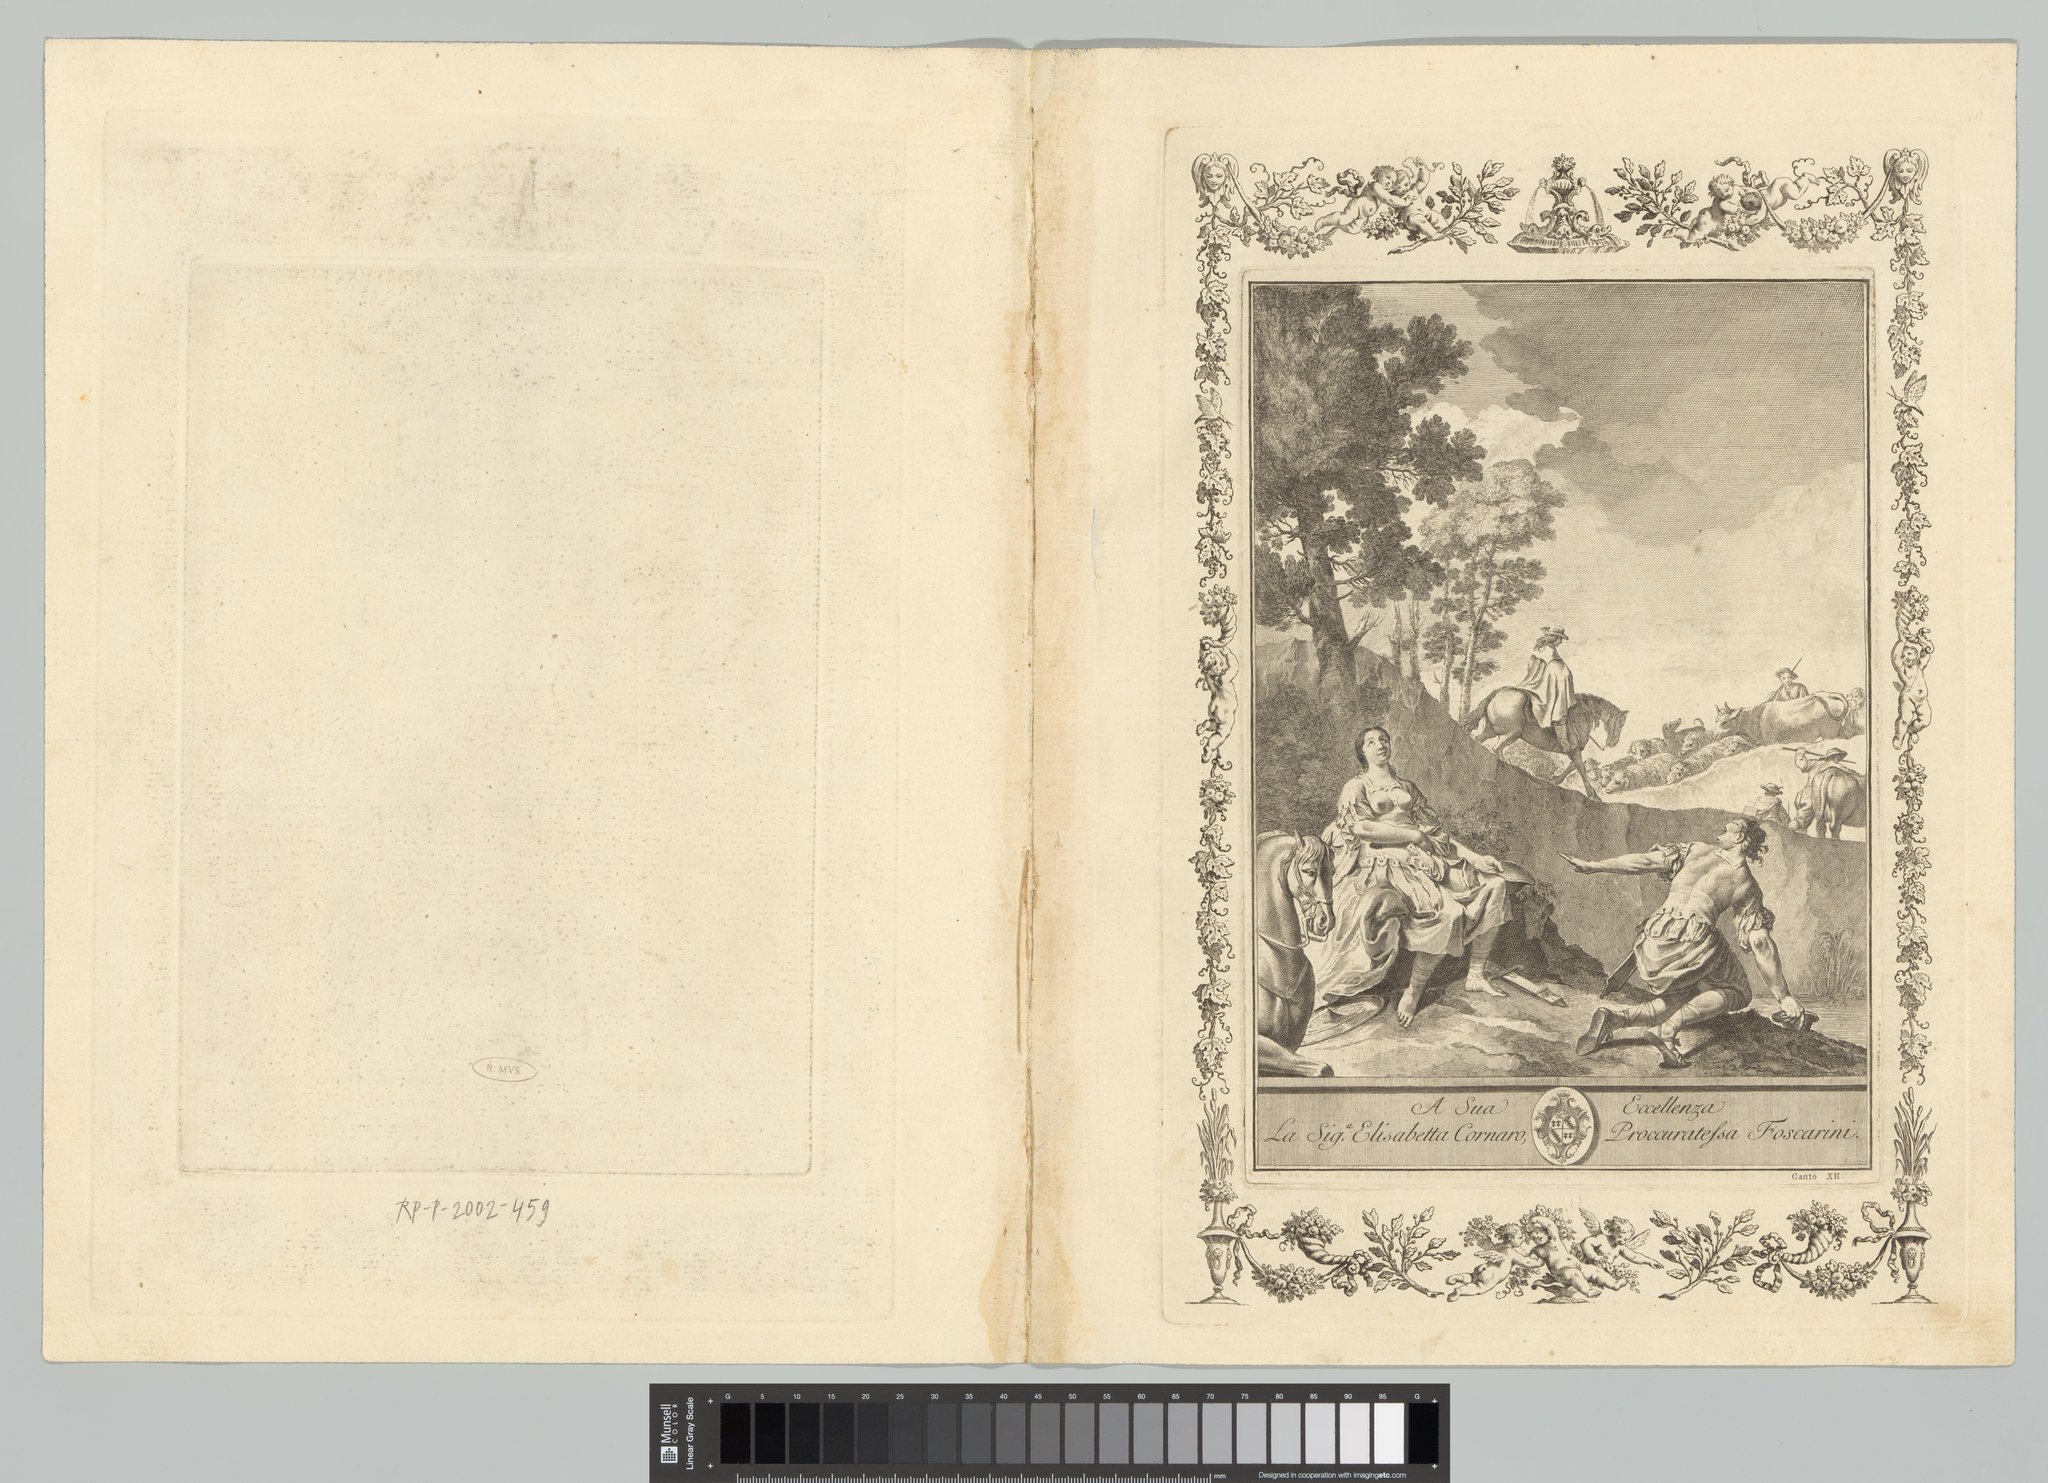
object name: print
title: Canto XII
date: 1745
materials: paper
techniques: etching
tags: fruits and vegetables ~ ornament, (scenes from) specific works of literature: tasso, gerusalemme liberata, armorial bearing, heraldry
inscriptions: collector's mark: Lugt 2228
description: Ornamentrand met bloemen, planten, cupido's en een fontein.